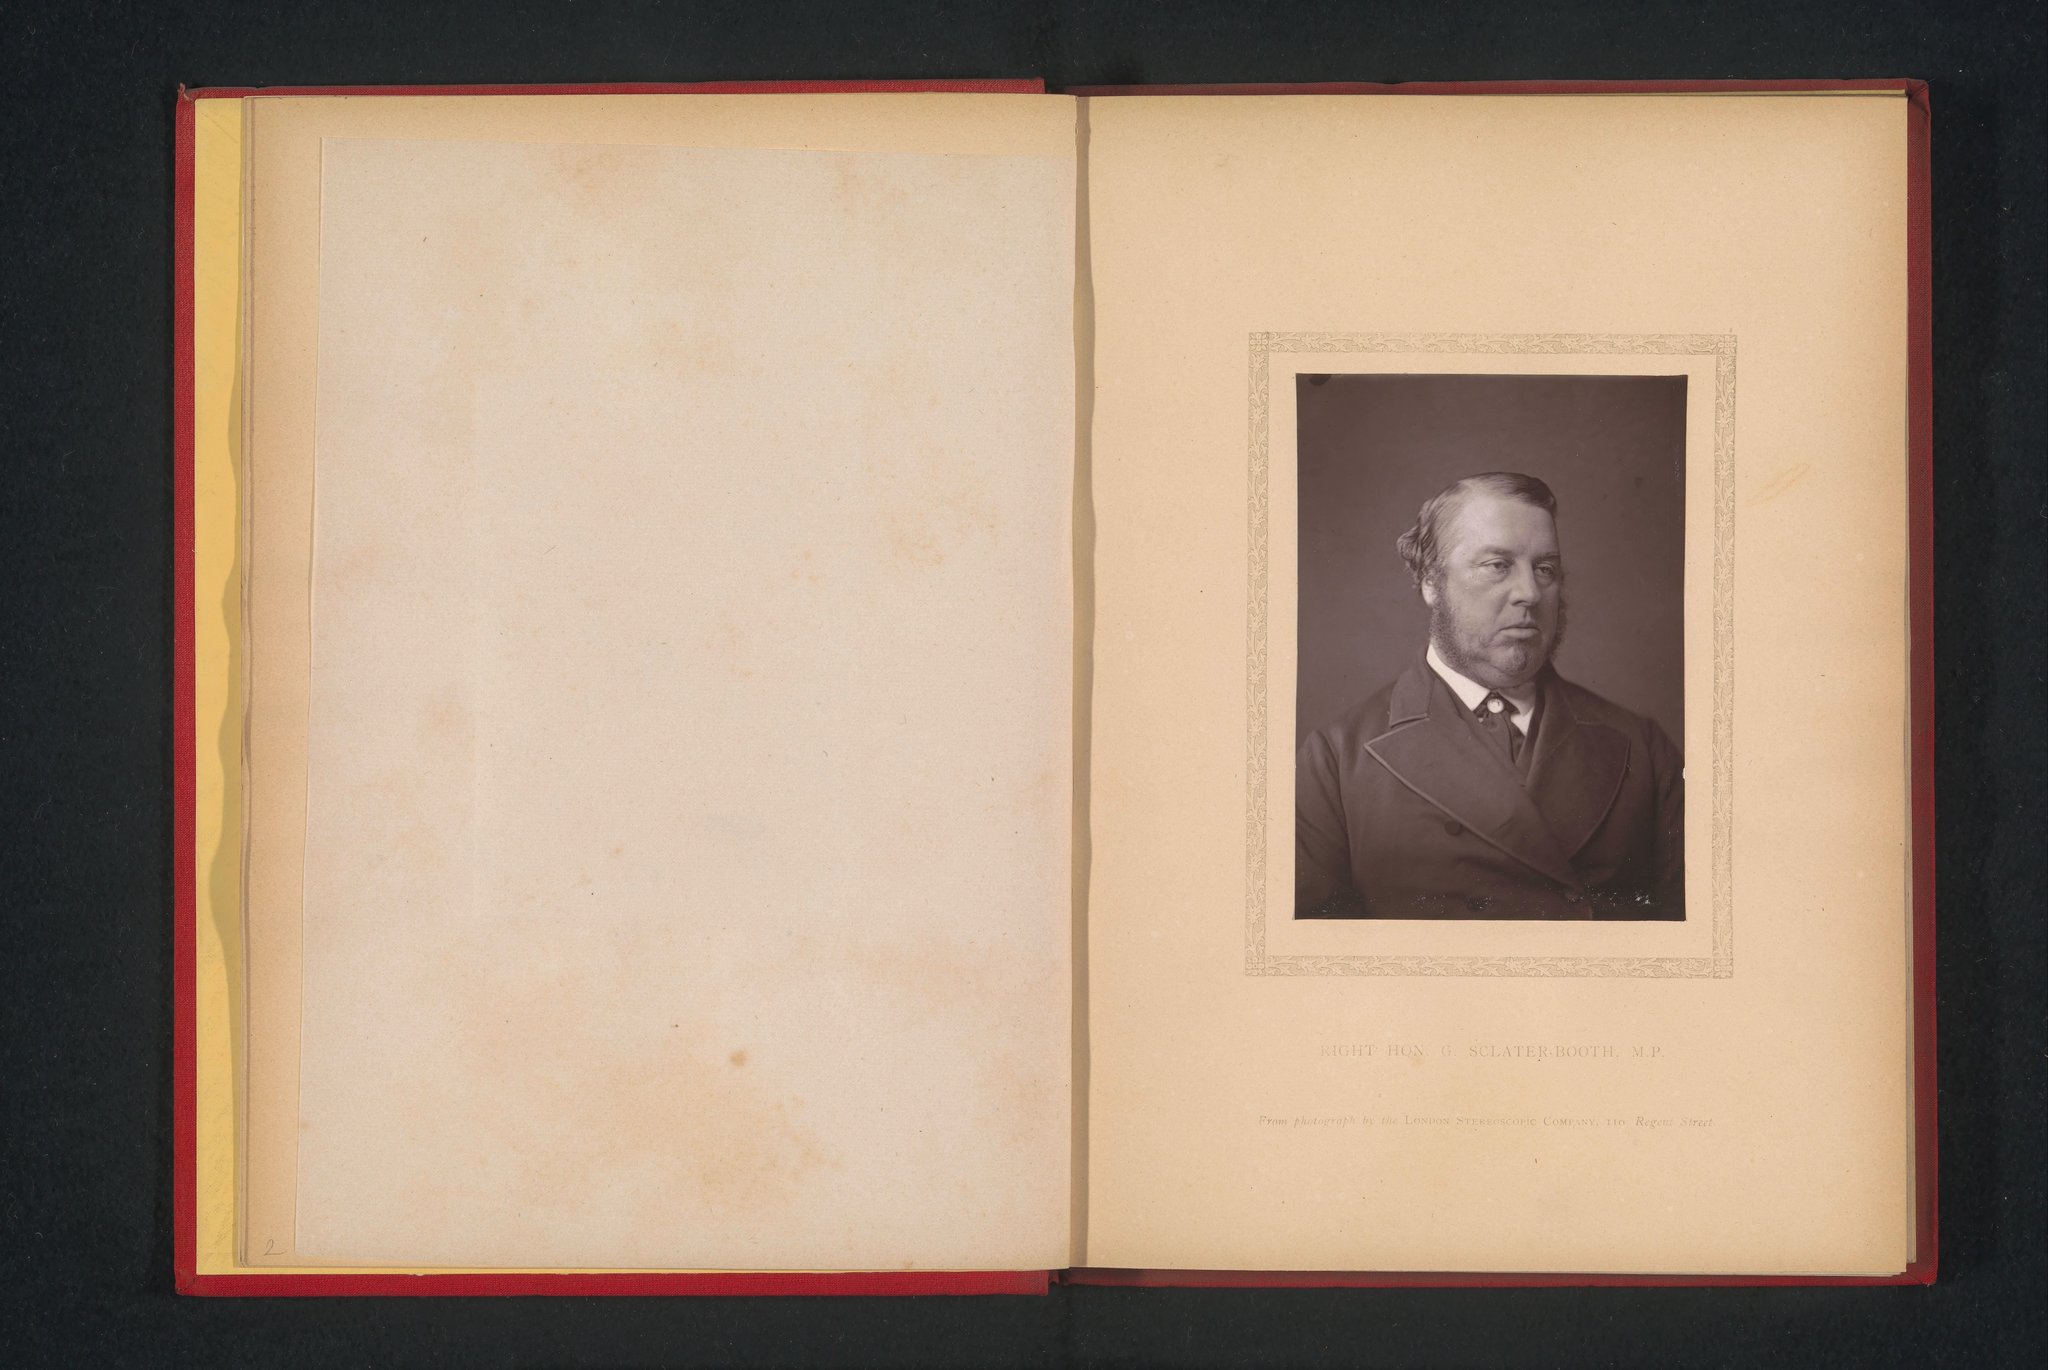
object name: page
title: Right hon. G. Sclater-Booth, M.P.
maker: Anonymous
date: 1871-1881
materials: paper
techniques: woodburytype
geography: london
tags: politician, politician, e.g. party leader